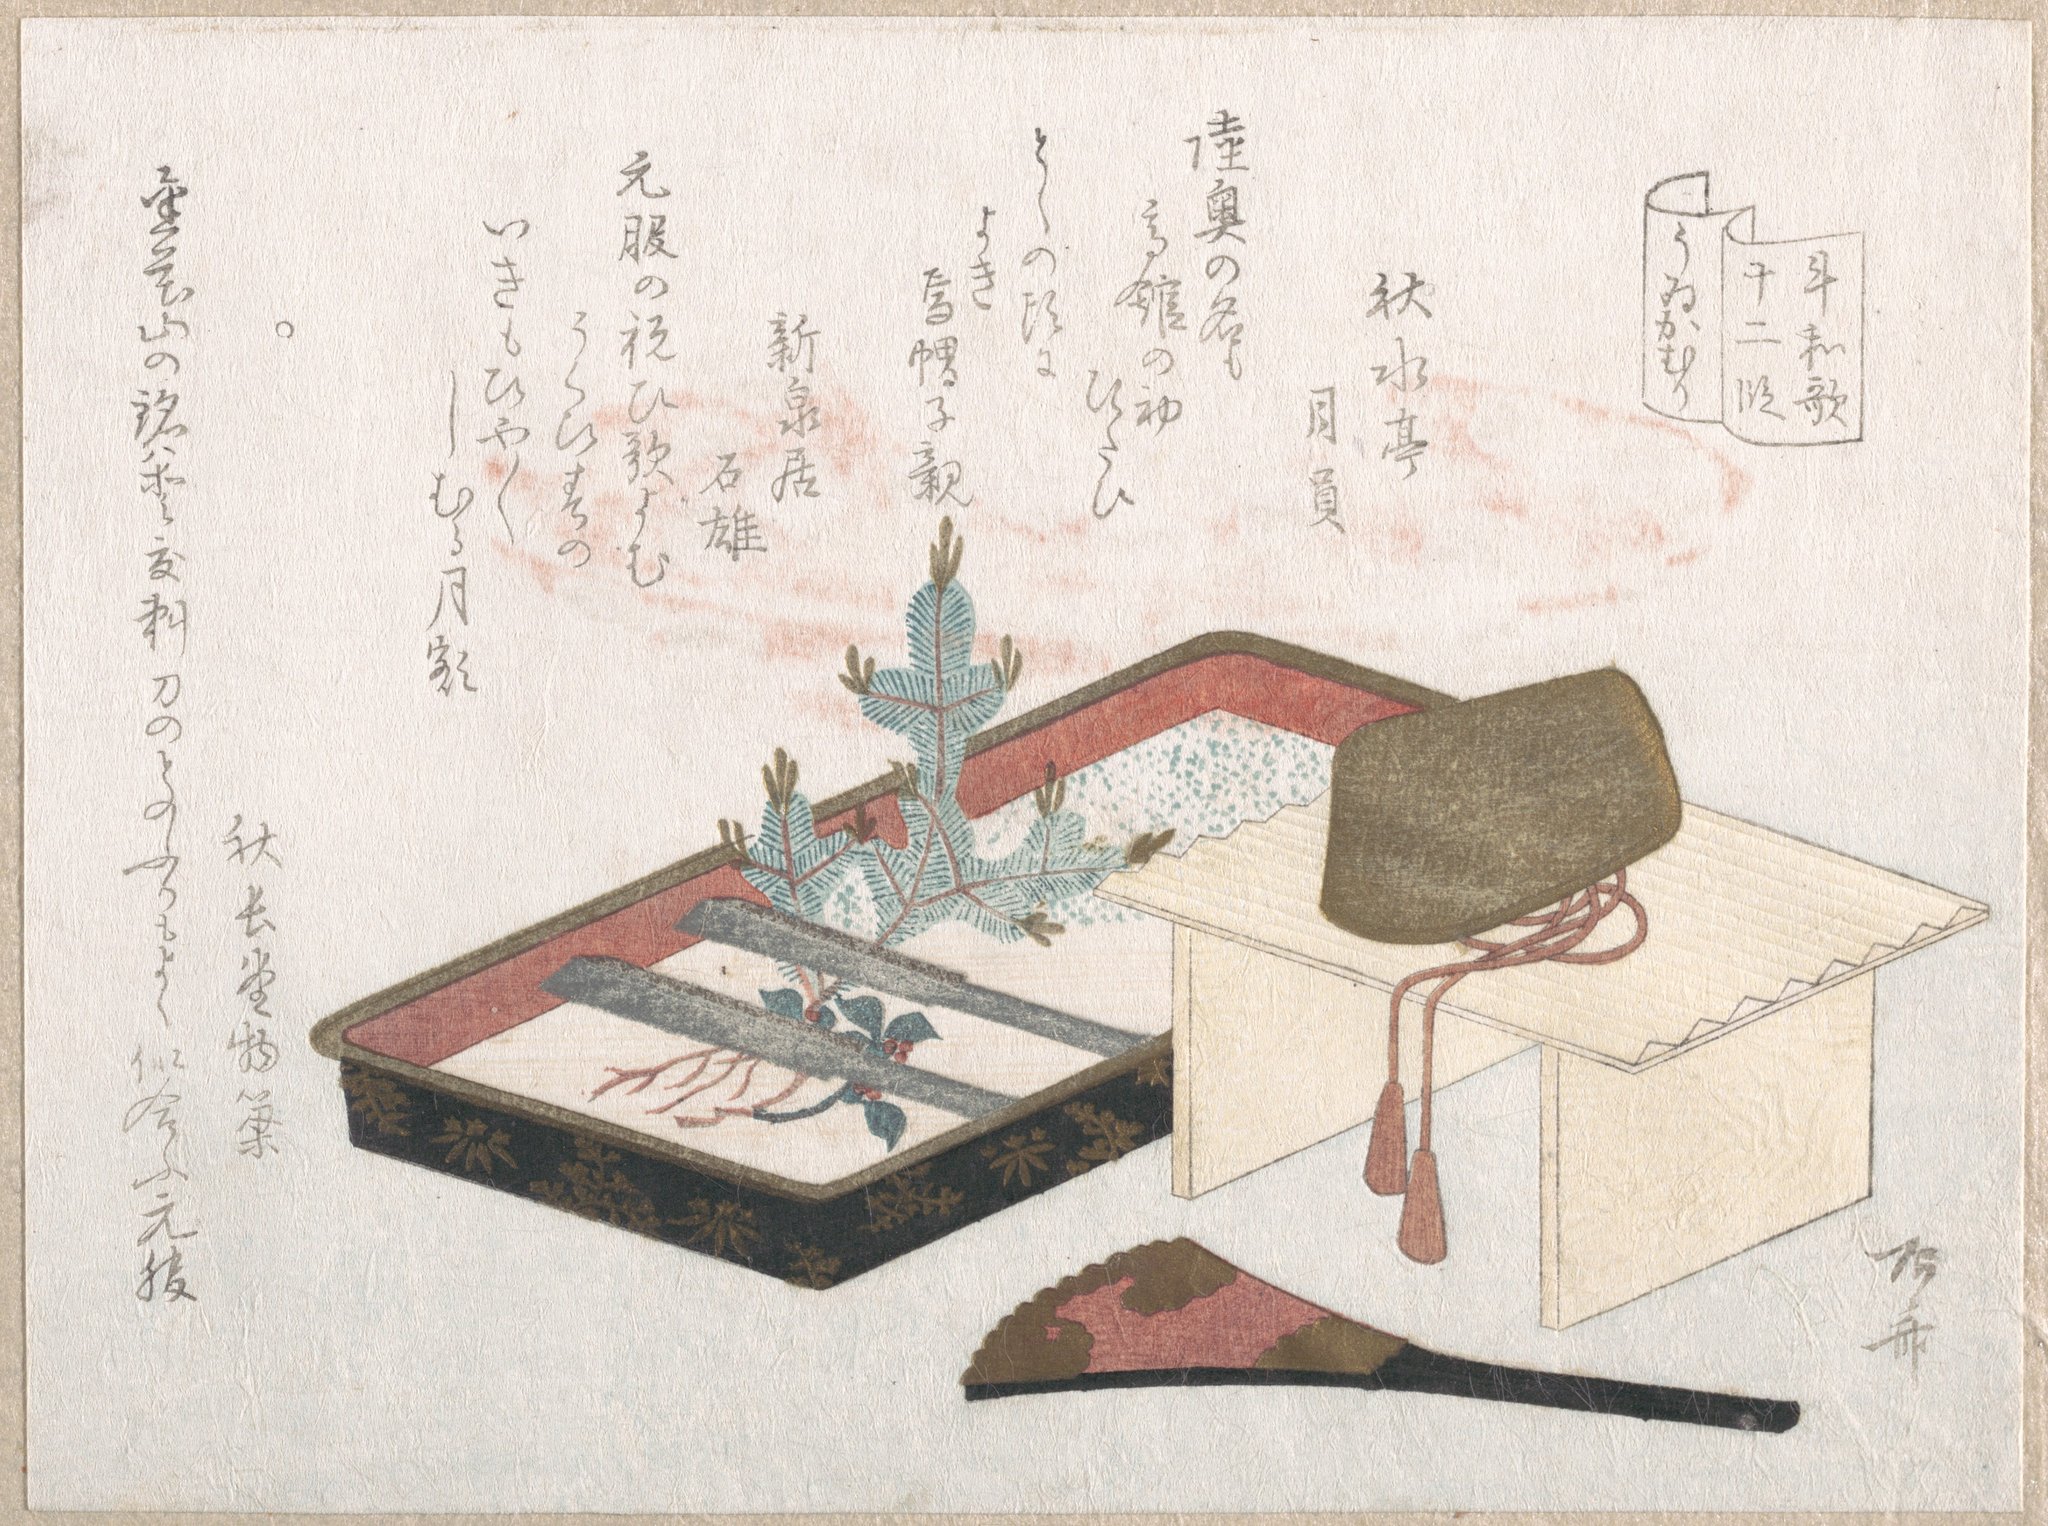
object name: print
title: Crown on a Table, Lacquer Tray with Young Pine and Fan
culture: japanese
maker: ryūryūkyo shinsai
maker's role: artist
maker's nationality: japanese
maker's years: 1799-1823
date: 1801-1900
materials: ink, paper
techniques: surimono, woodblock print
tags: fans,trees,tables,trays